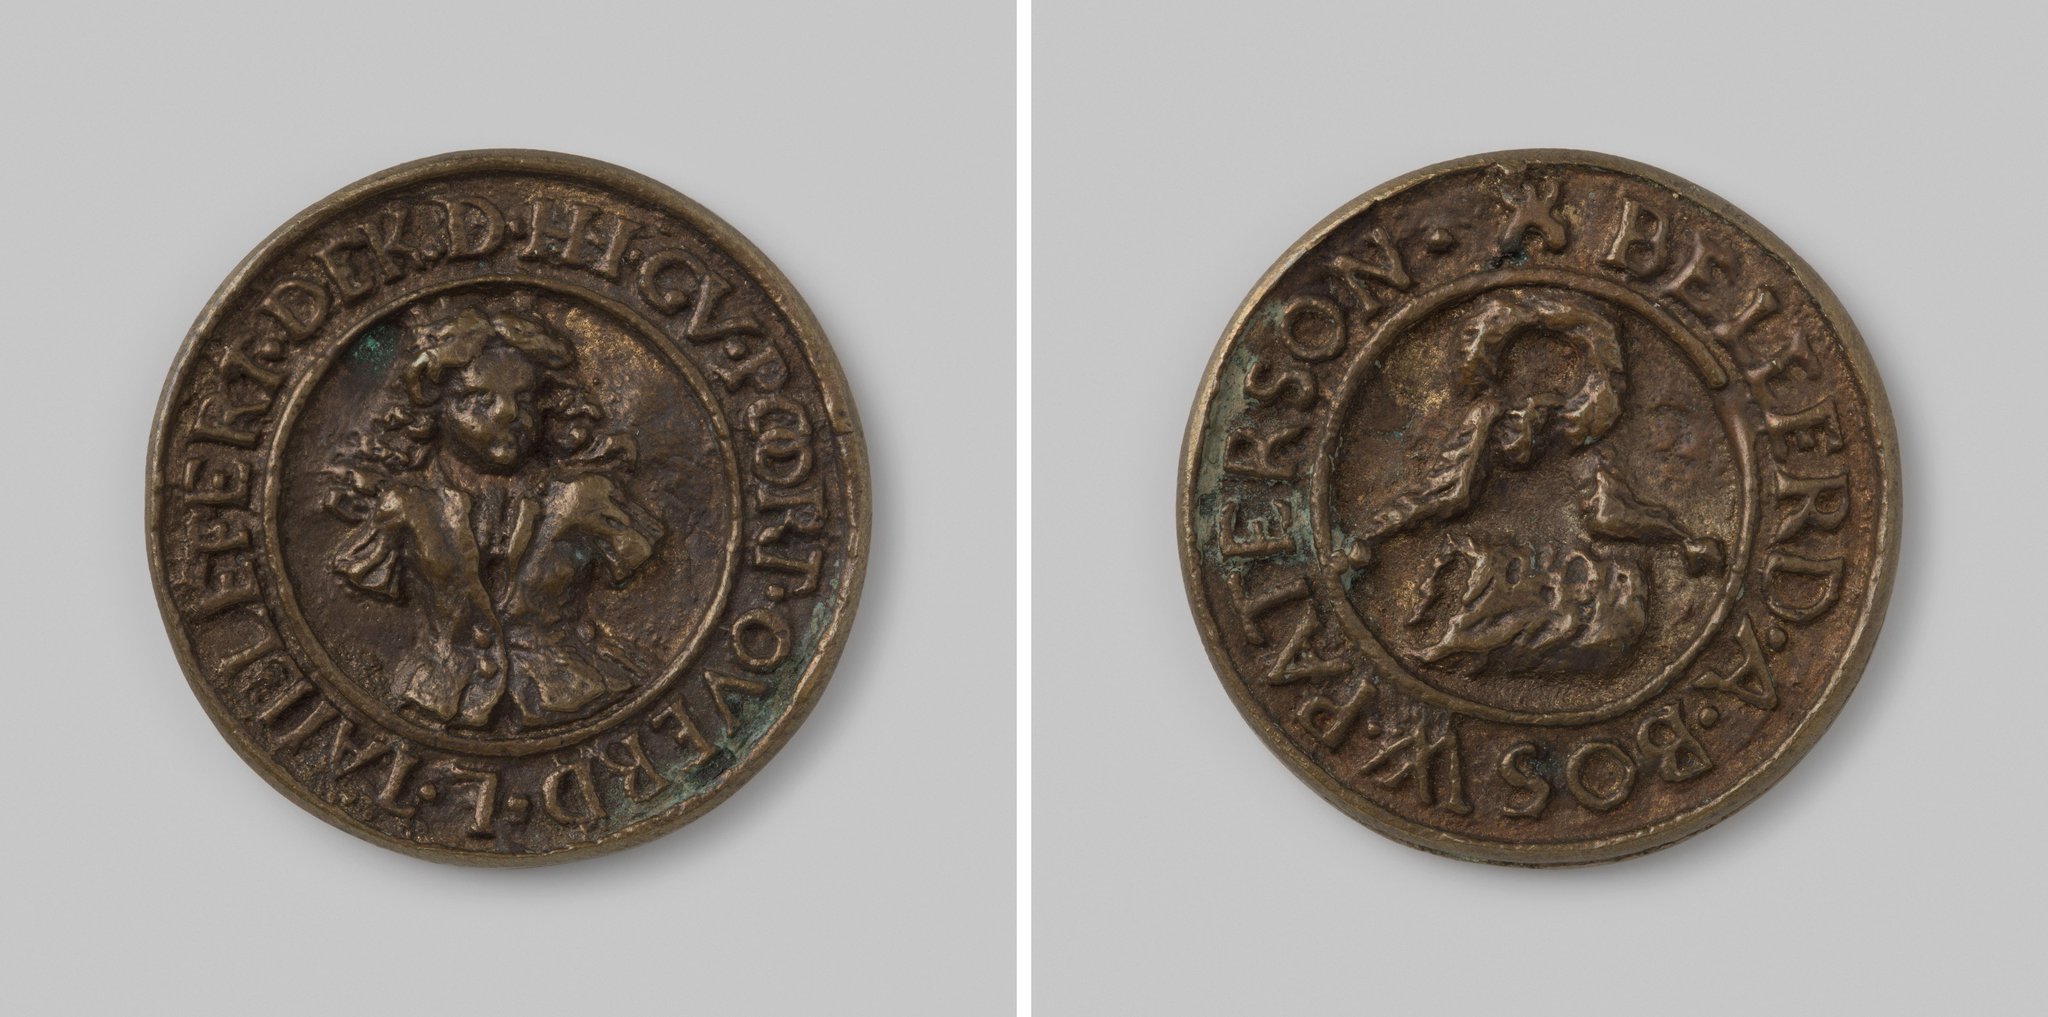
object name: medal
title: Presentiepenning van het Bontwerkers- en pruikenmakersgilde te Middelburg, 1718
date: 1718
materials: brass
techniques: casting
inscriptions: circumscription: ‘D H I GV POORT OVERD L TAIL LEFERT DEK’, circumscription: ‘(burcht) BELEERD A BOS W PATERSON’, inscription: ‘2’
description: Gegoten messing penning, op de voorzijde een borstbeeld met wambuis en pruik, met omschrift, op de keerzijde een bontkraag, een mof en cijfer 2, met omschrift